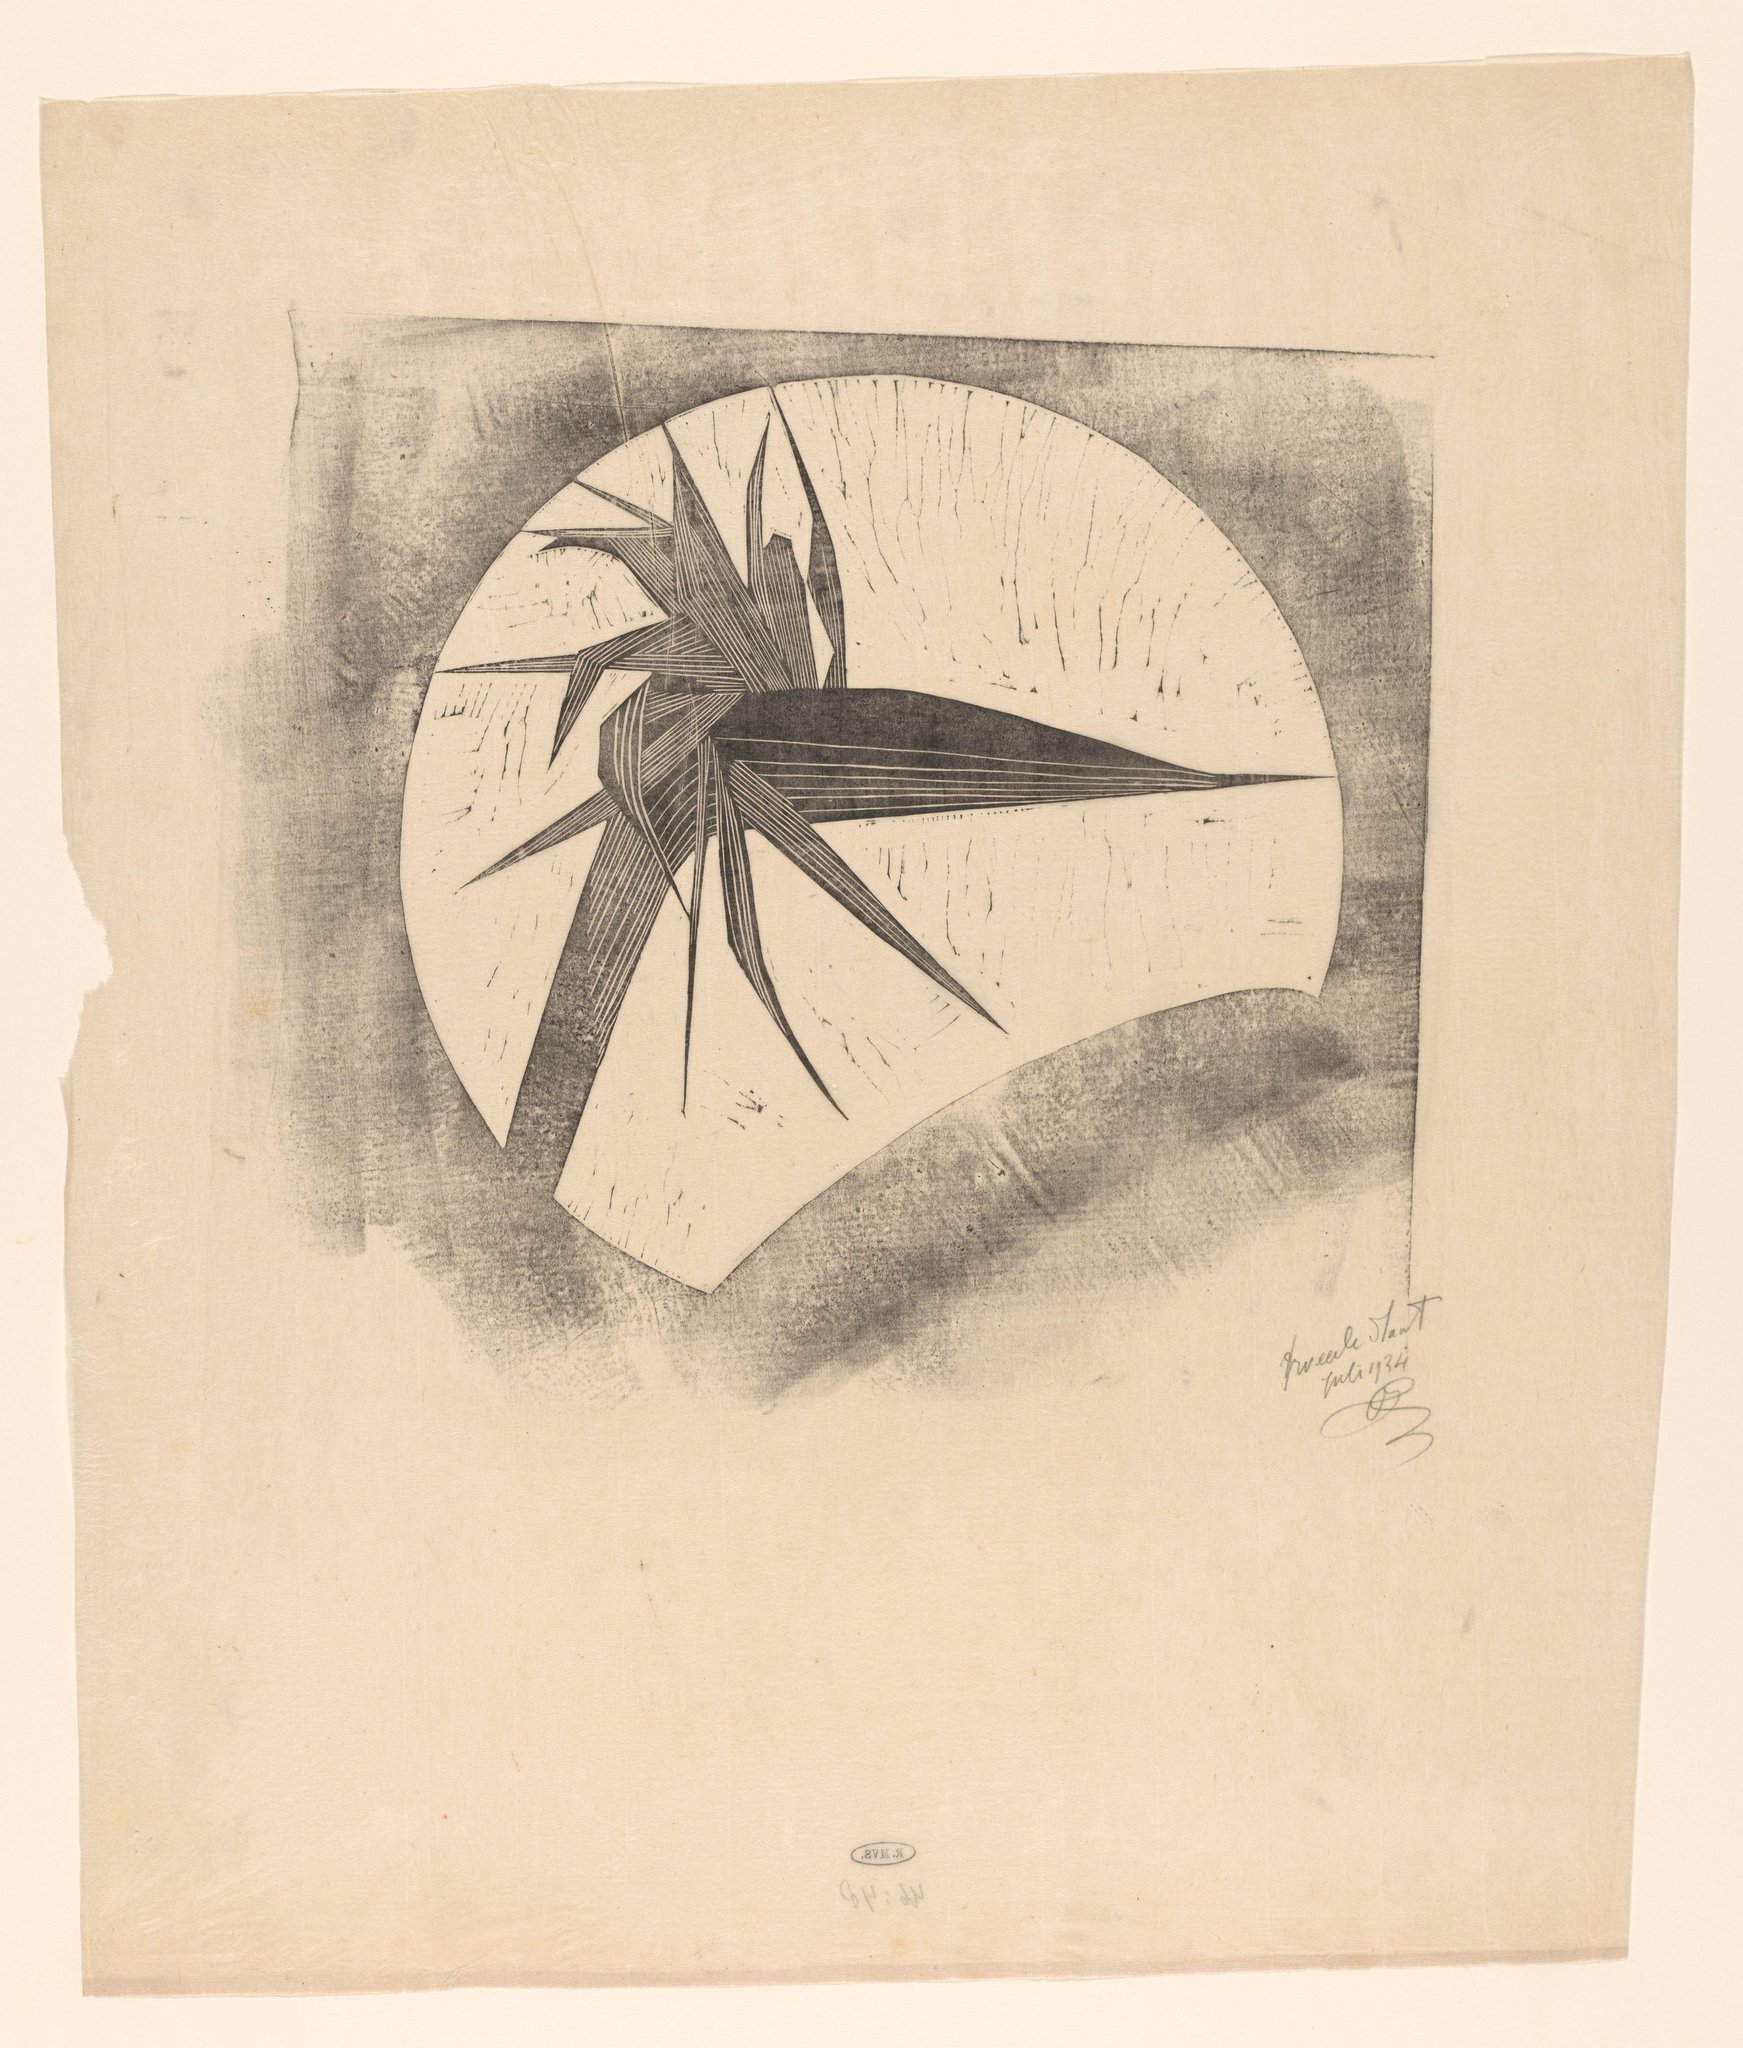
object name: print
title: Verdorde strelitzia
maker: samuel jessurun de mesquita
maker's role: draughtsman, print maker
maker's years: 1868-1944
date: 1907-1934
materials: paper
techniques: woodcut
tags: flowers (+ dying plant)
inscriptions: collector's mark: Lugt 2228